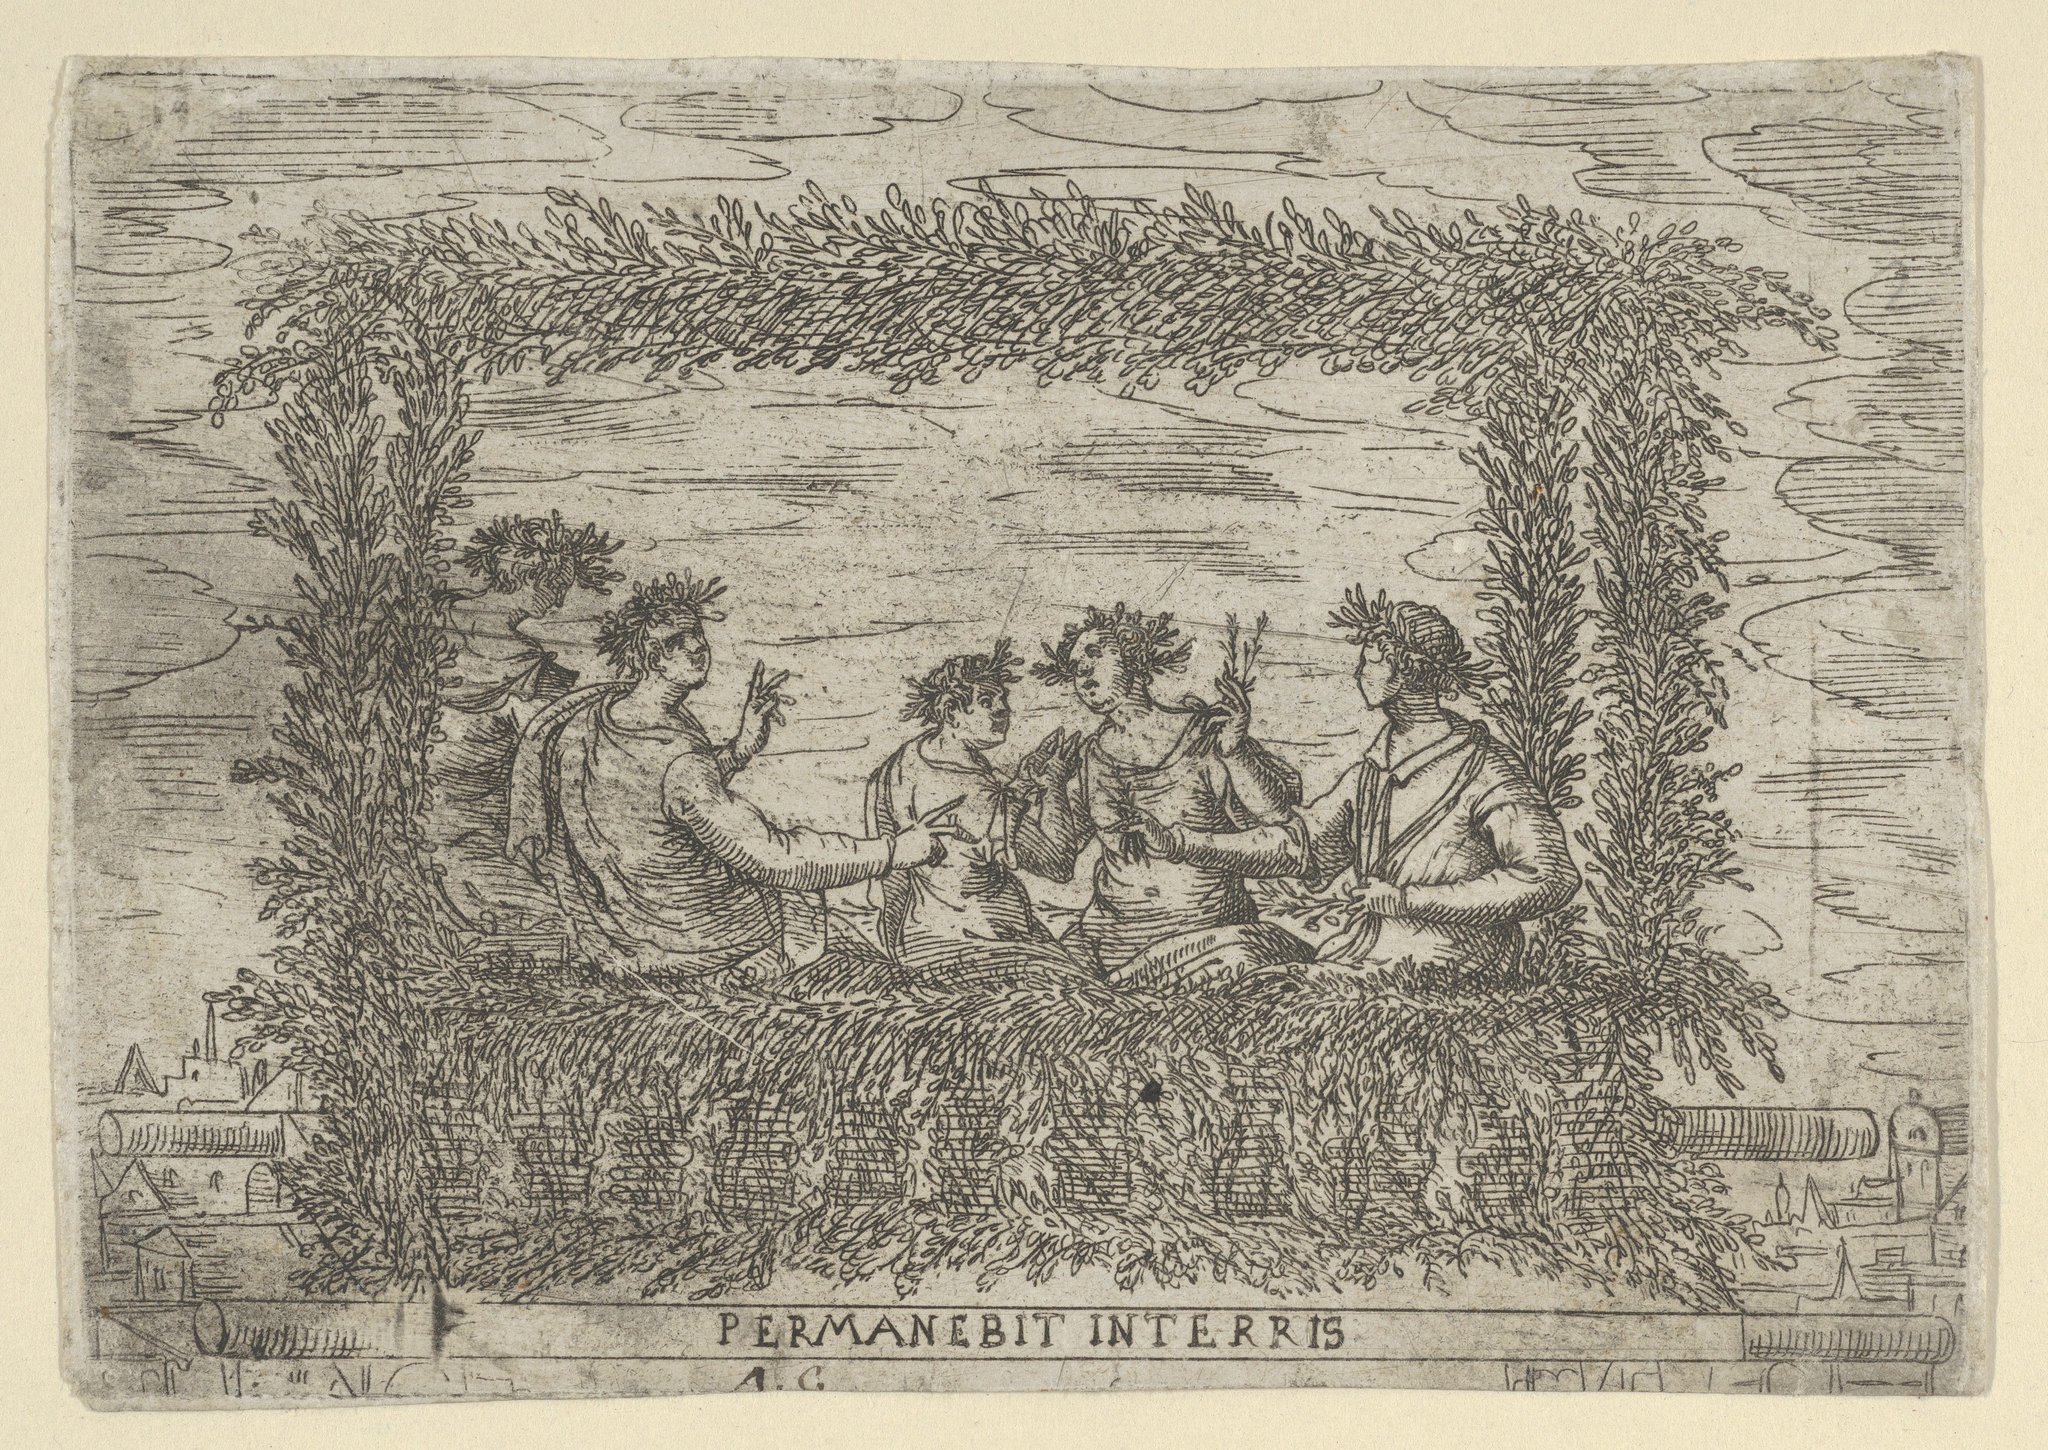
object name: print, fete, ornament architecture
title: Permanebit in Terris (Continue on Earth)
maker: anonymous, italian, 16th century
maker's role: artist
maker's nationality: italian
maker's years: 1500-1600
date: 1501-1600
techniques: etching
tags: men